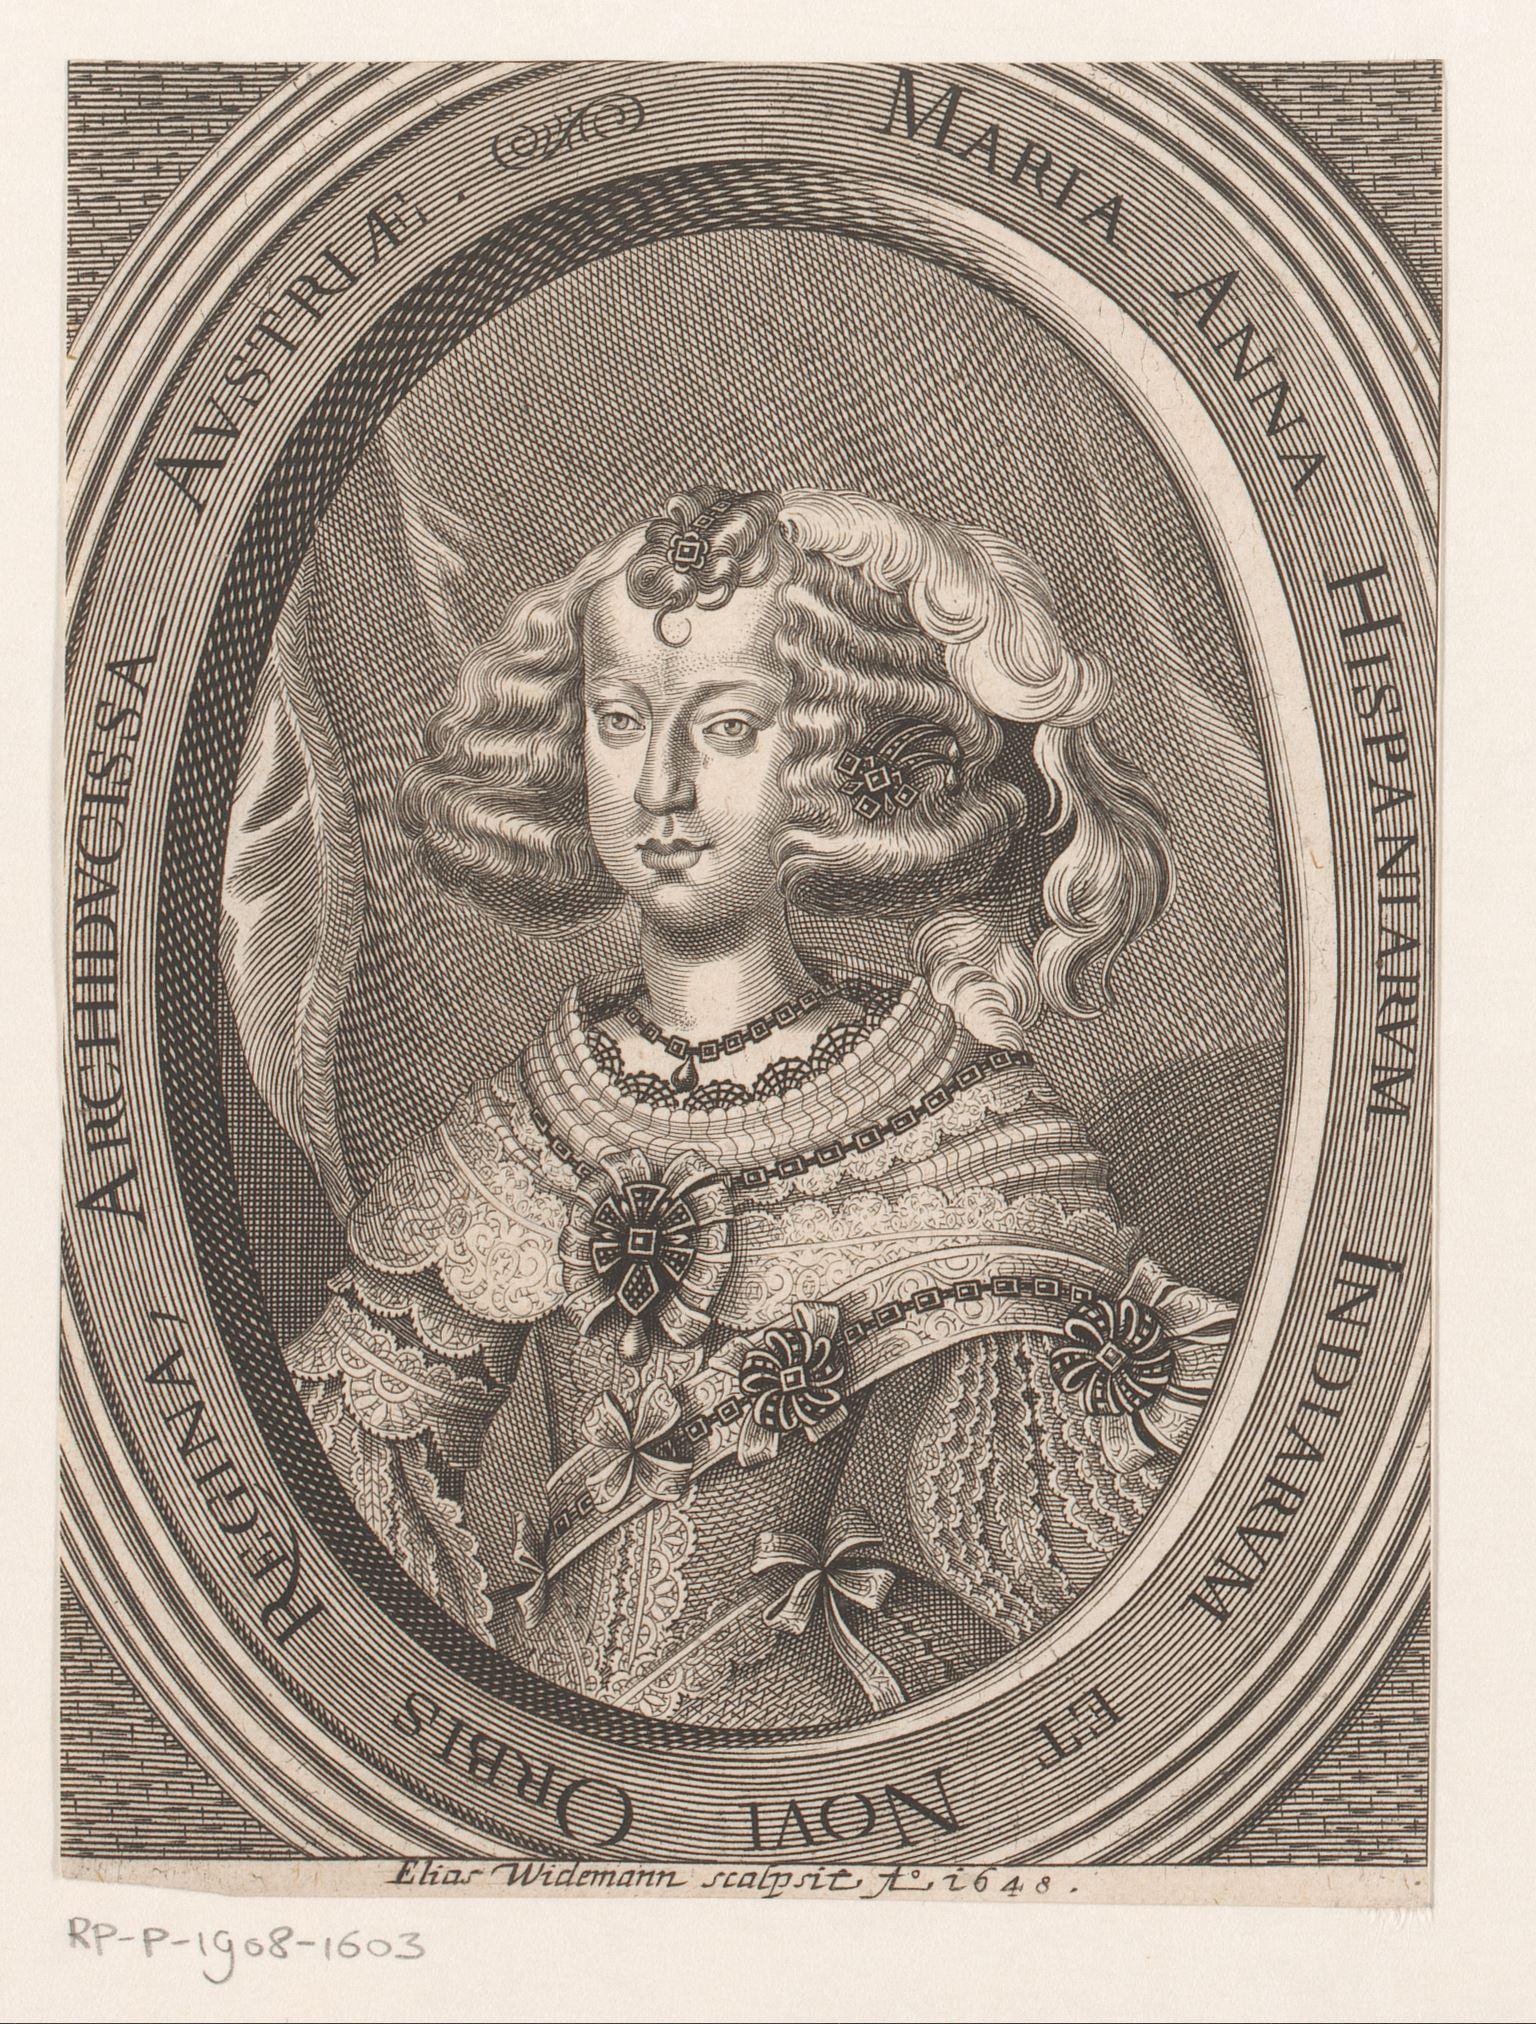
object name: print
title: Portret van Maria Anna, koningin van Spanje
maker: elias widemann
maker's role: print maker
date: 1648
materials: paper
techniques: engraving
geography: vienna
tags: vienna, maria anna van oostenrijk (koningin van spanje), historical persons, queen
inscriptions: collector's mark: Lugt 2228